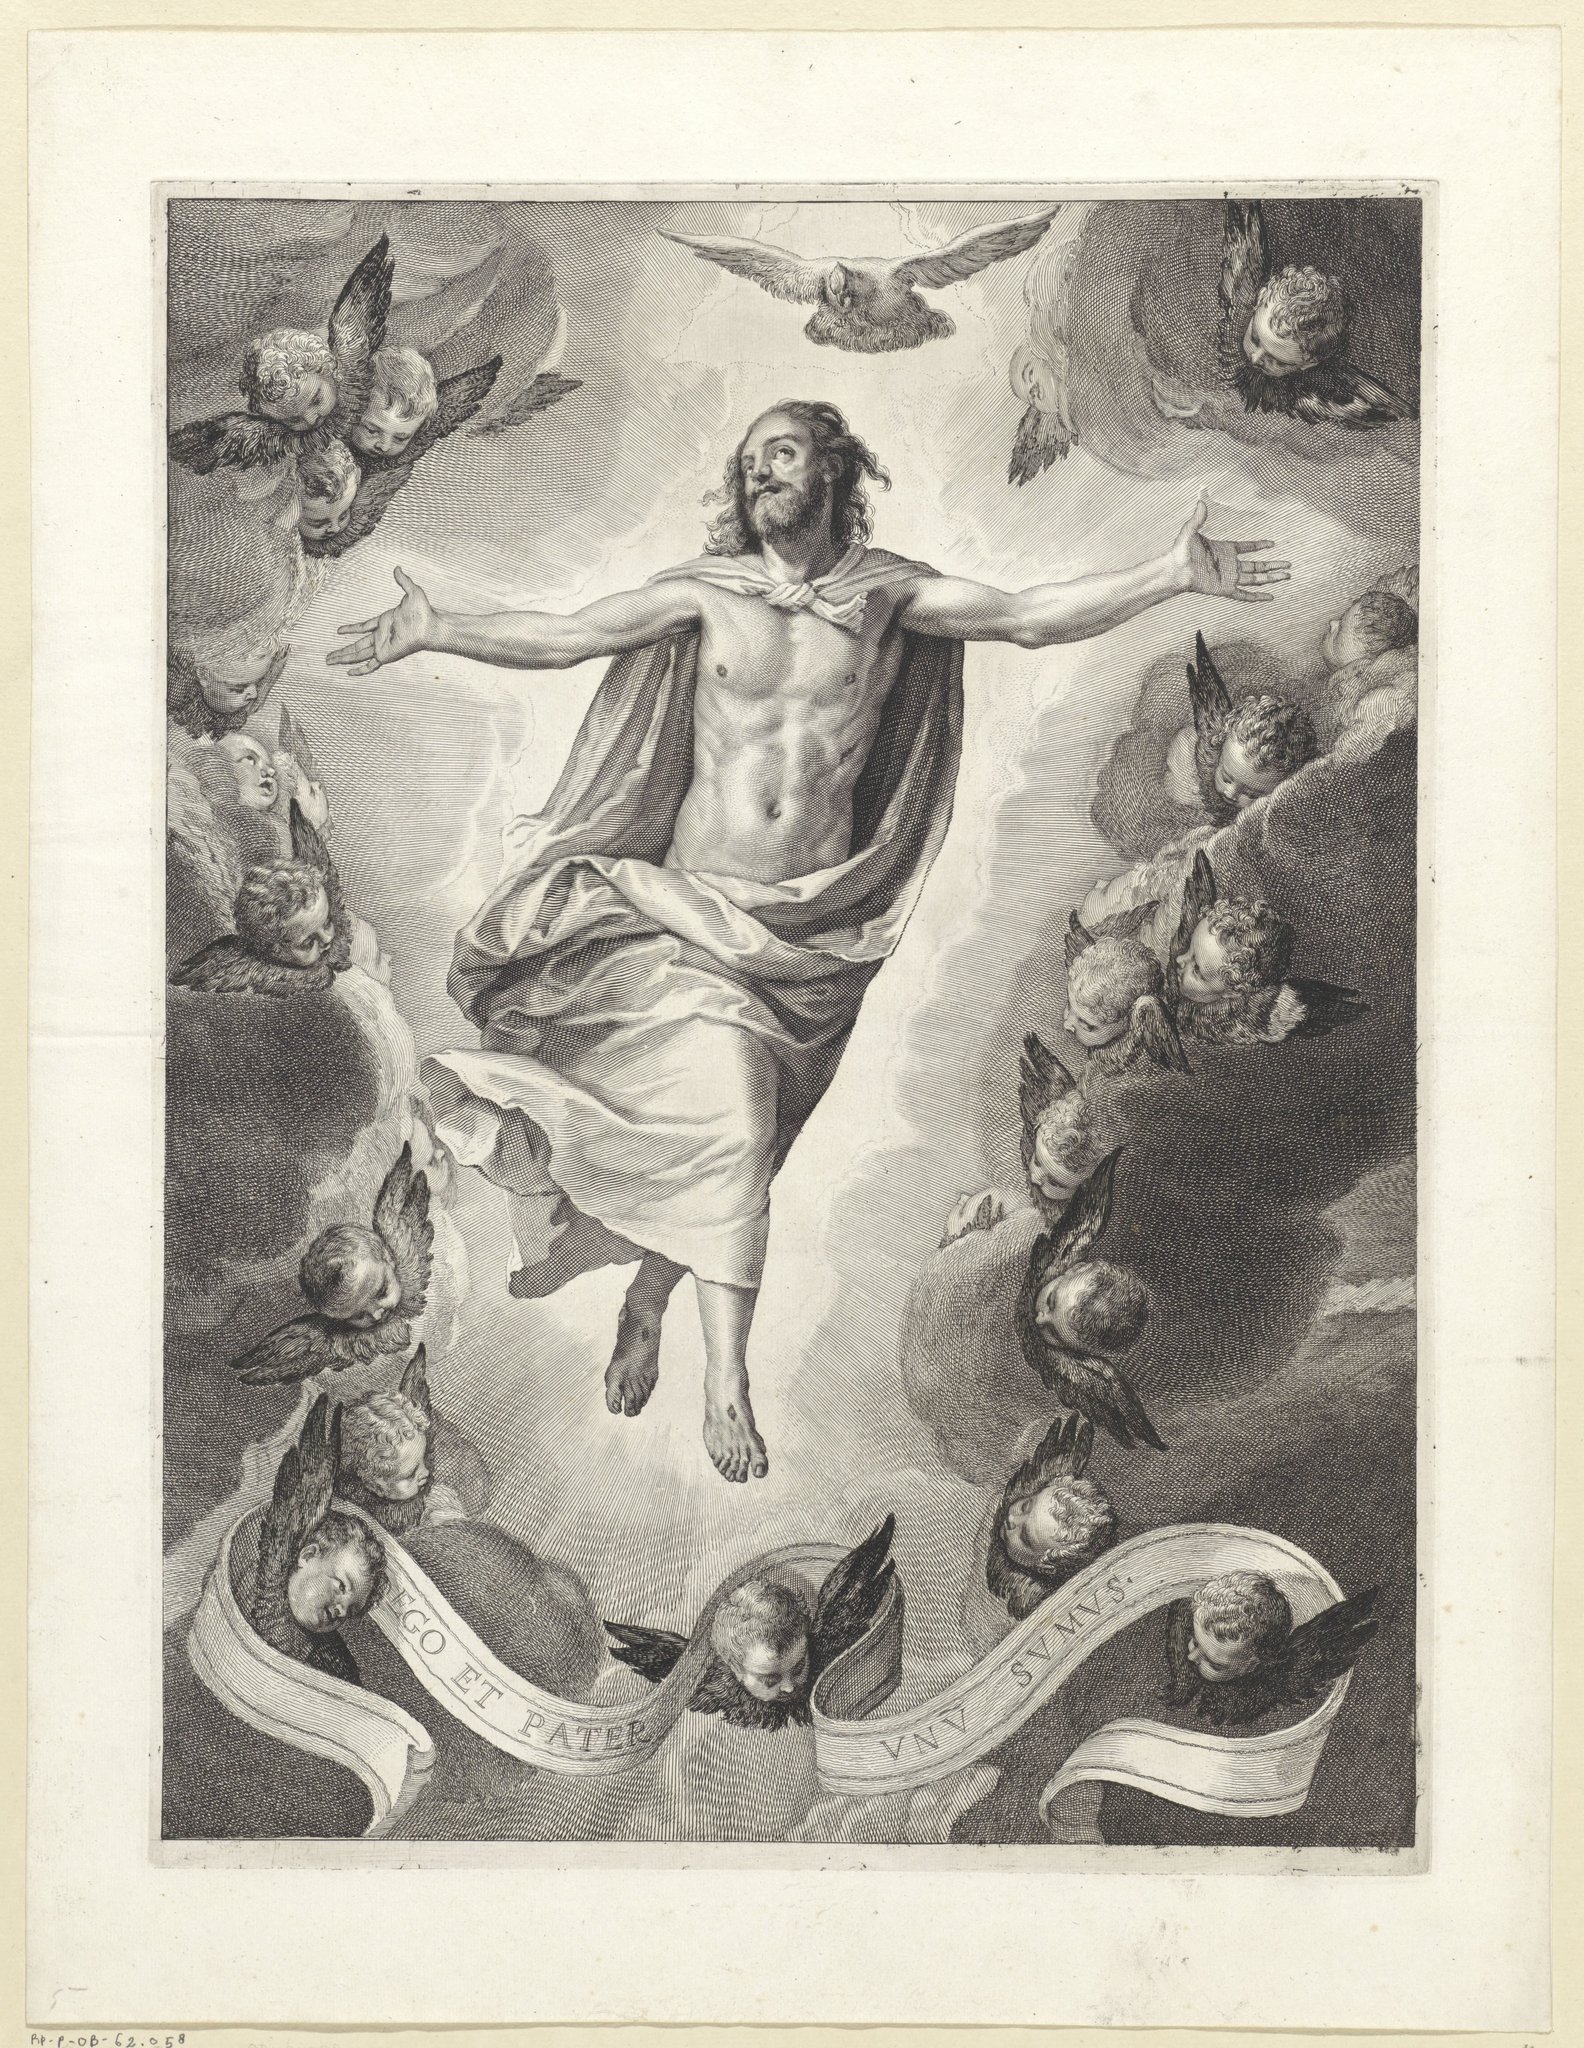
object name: print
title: Hemelvaart van Christus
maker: cornelis visscher (ii)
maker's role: draughtsman, painter, print maker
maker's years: 1628-1658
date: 1638-1658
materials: paper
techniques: engraving, etching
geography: amsterdam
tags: the ascension (christ surrounded by radiant light or in a mandorla)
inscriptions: collector's mark: Lugt 240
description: Deze prent is ook gebruikt in: Variarum imaginum a celeberrimis artificibus pictarum caelaturae, elegantissimis Tabulis repraesentatae (...) sunt. Amsterdam, nummer 13.